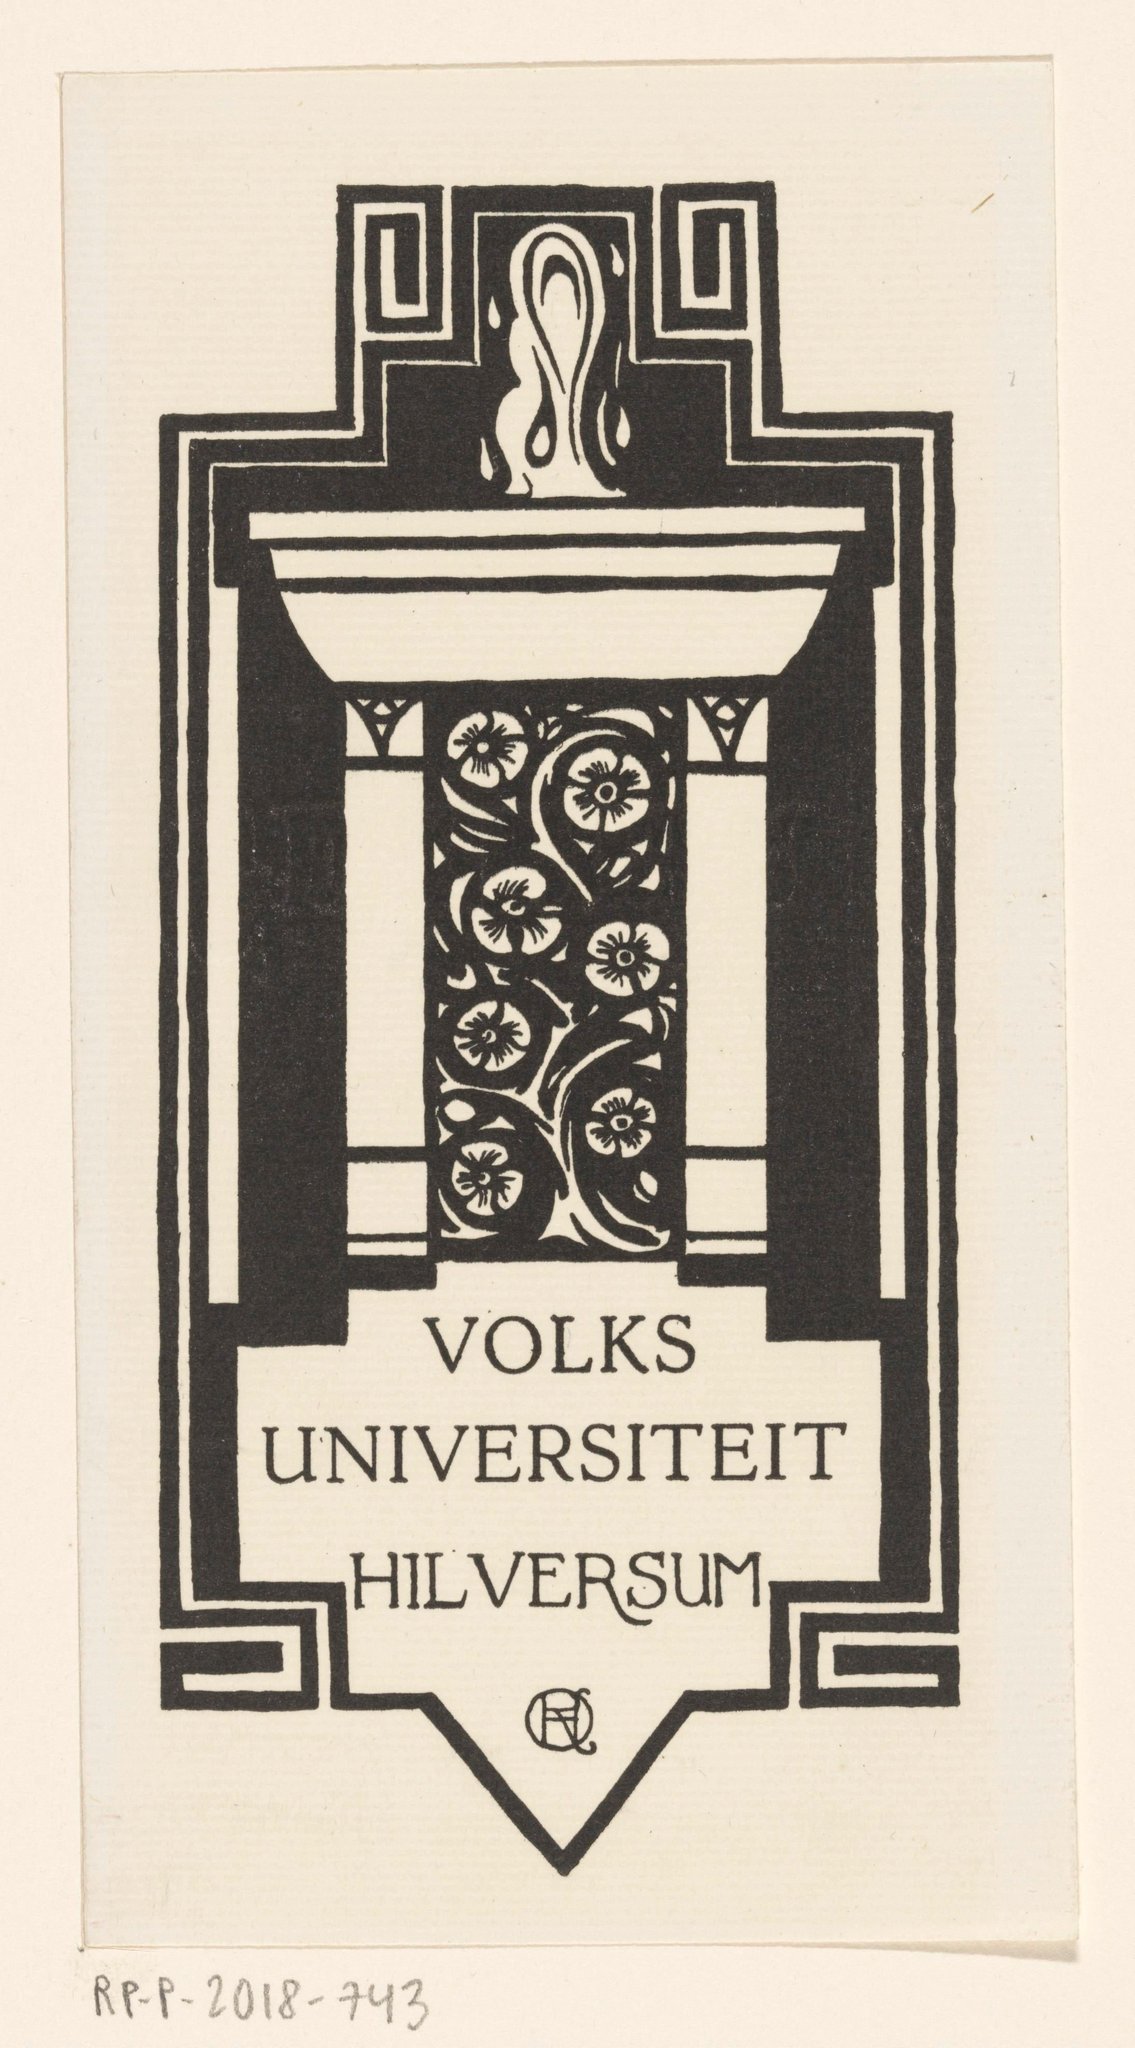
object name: print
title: Zuil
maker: richard nicolaüs roland holst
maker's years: 1868-1938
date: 1920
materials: paper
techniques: line block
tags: column, pillar ~ architecture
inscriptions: number: ‘25’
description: Ontwerp voor: Volksuniversiteit Hilversum.